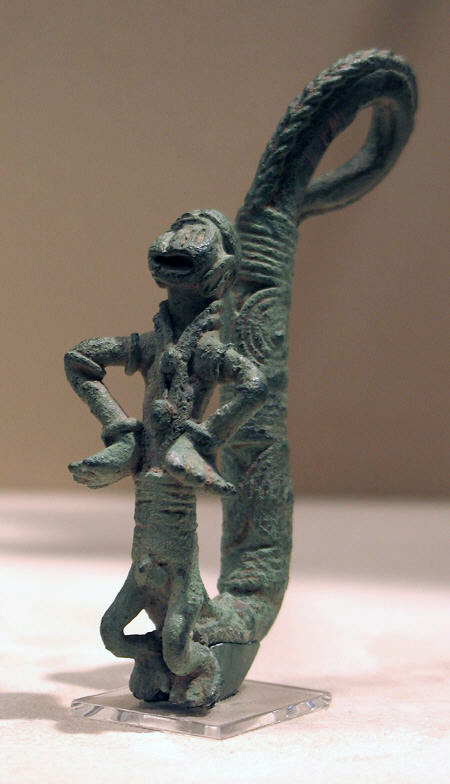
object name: hook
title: Hook(?) with Human or Monkey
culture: thai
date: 300 BCE-200 CE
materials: bronze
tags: monkeys